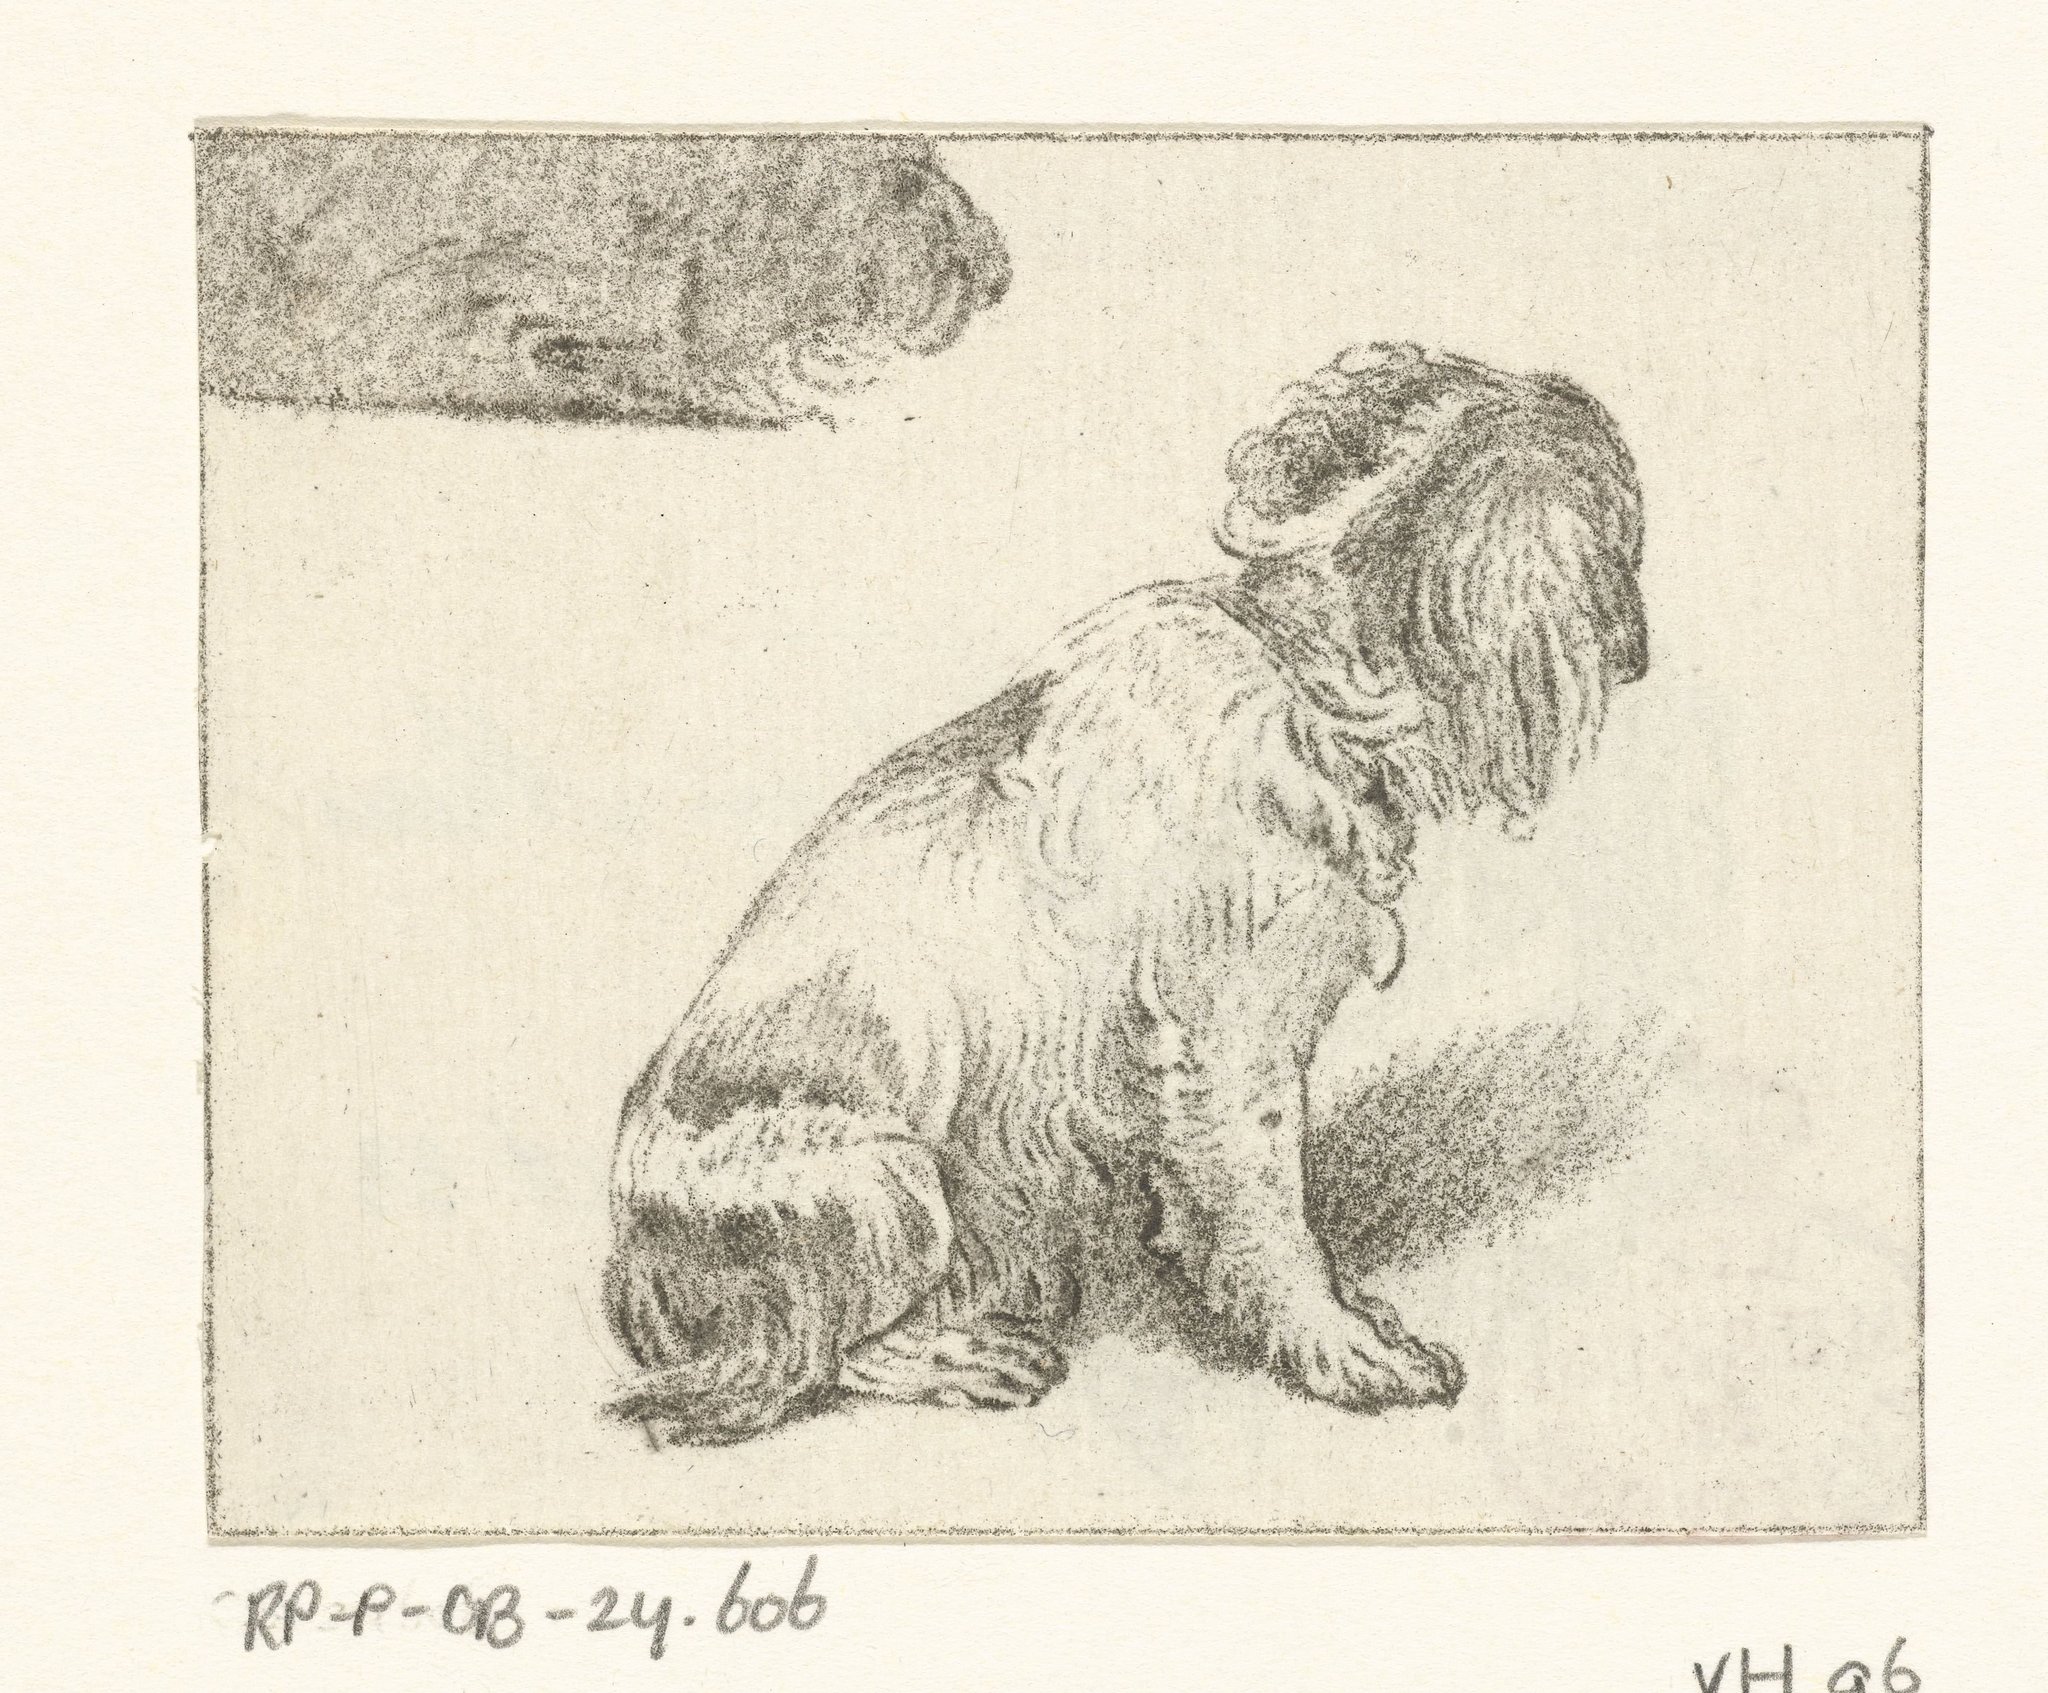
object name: print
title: Zittend hondje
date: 1777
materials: paper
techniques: printmaking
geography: amsterdam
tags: dog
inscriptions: collector's mark: Lugt 2725, collector's mark: Lugt 12